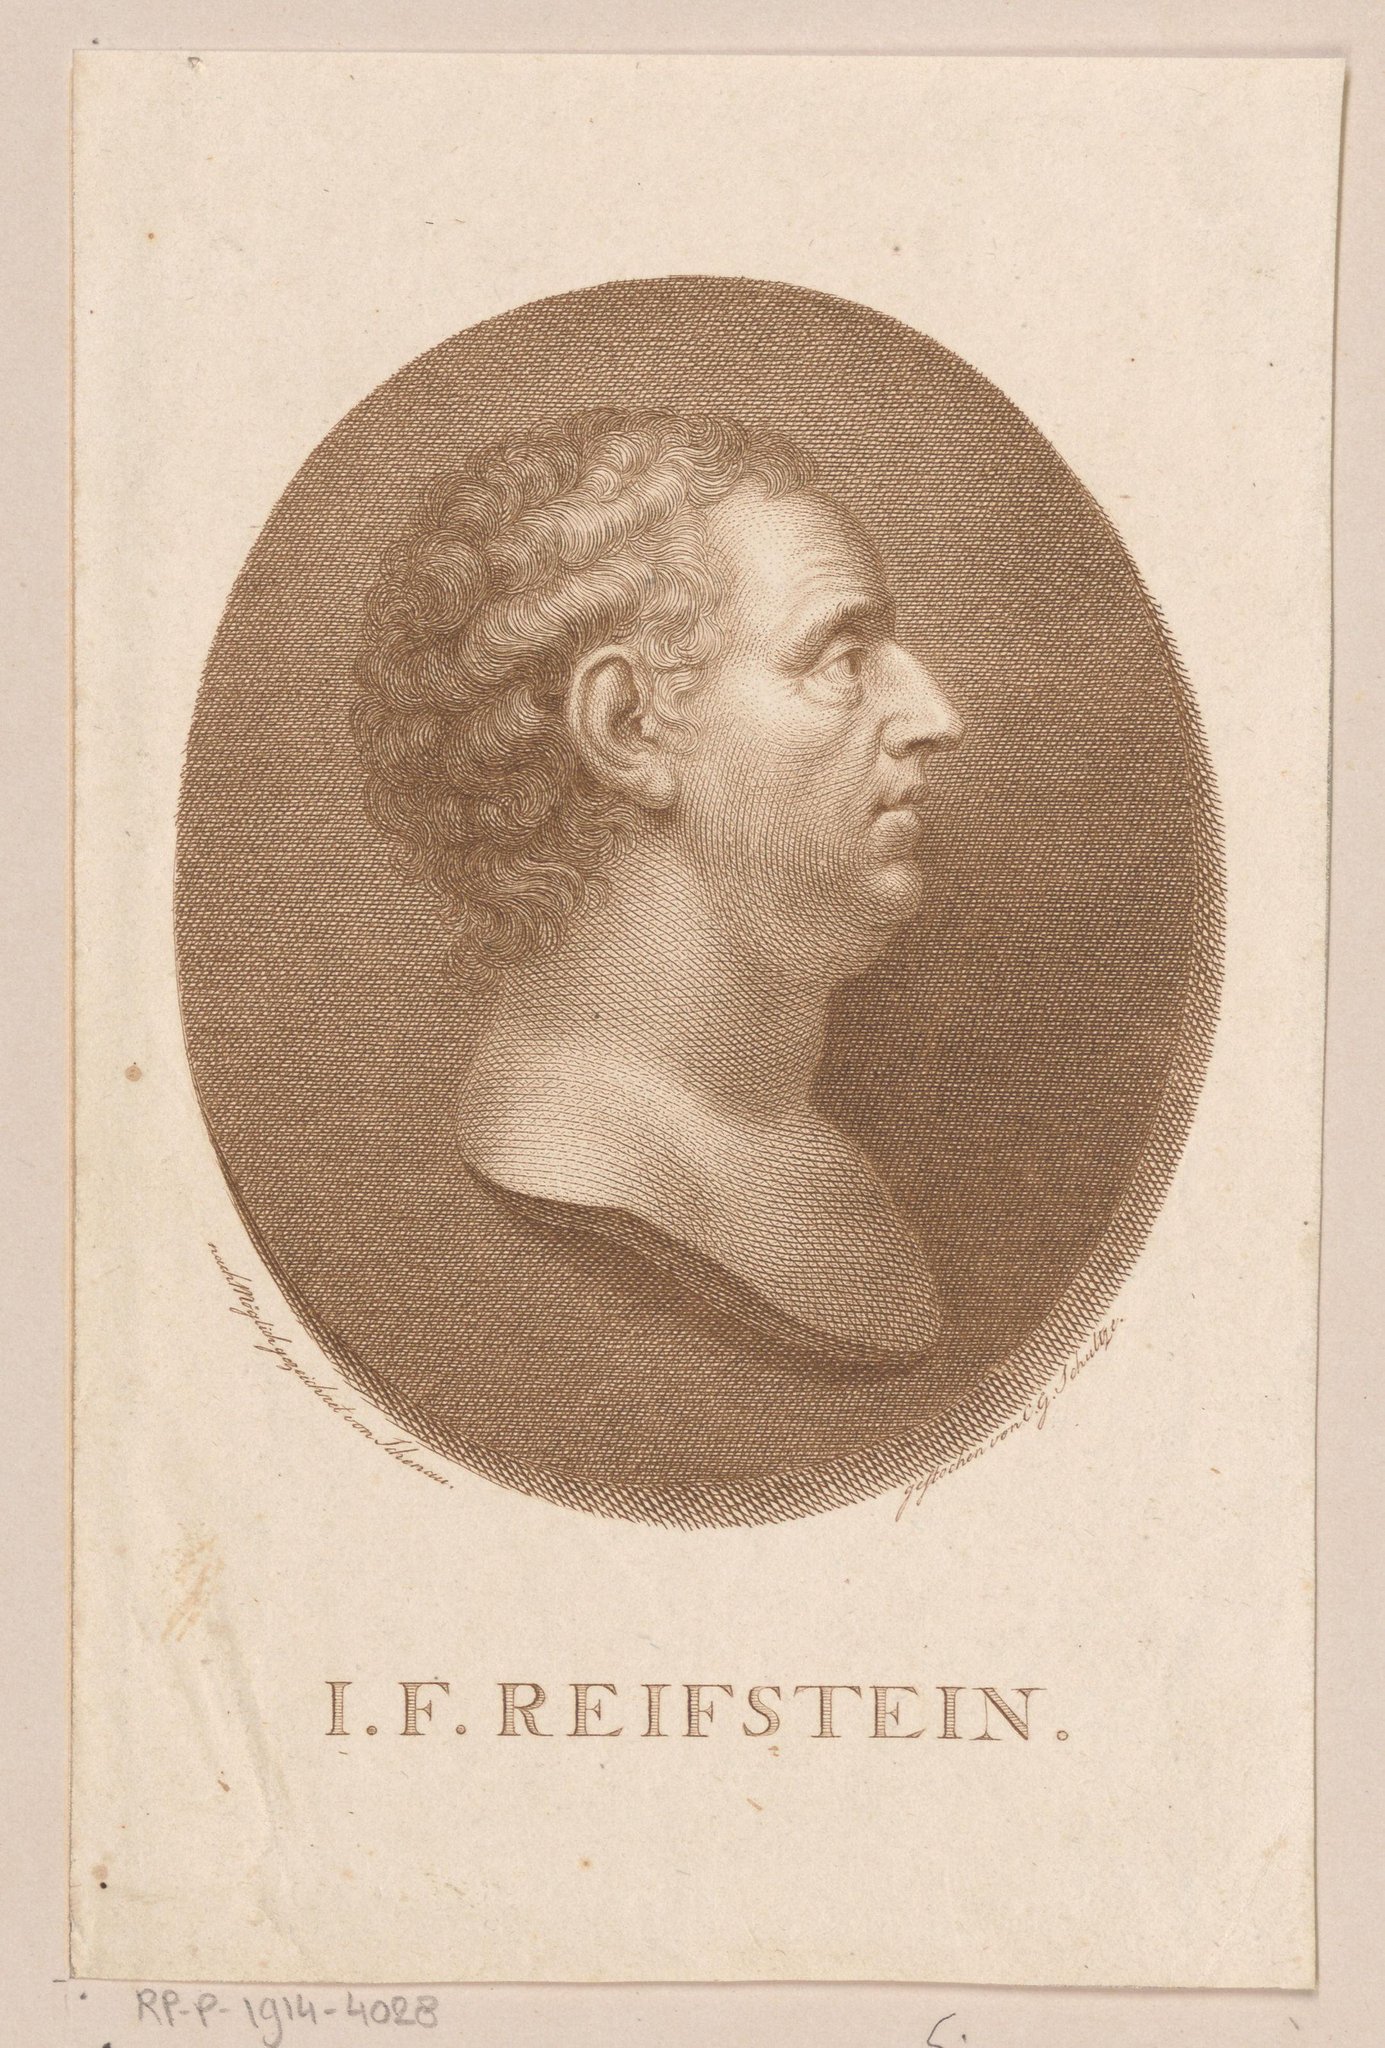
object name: print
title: Portret van Johann Friedrich Reiffenstein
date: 1759-1819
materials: paper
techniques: engraving, etching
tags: rome, painter, print maker, sculptor, johann friedrich reiffenstein, historical persons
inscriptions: collector's mark: Lugt 2228